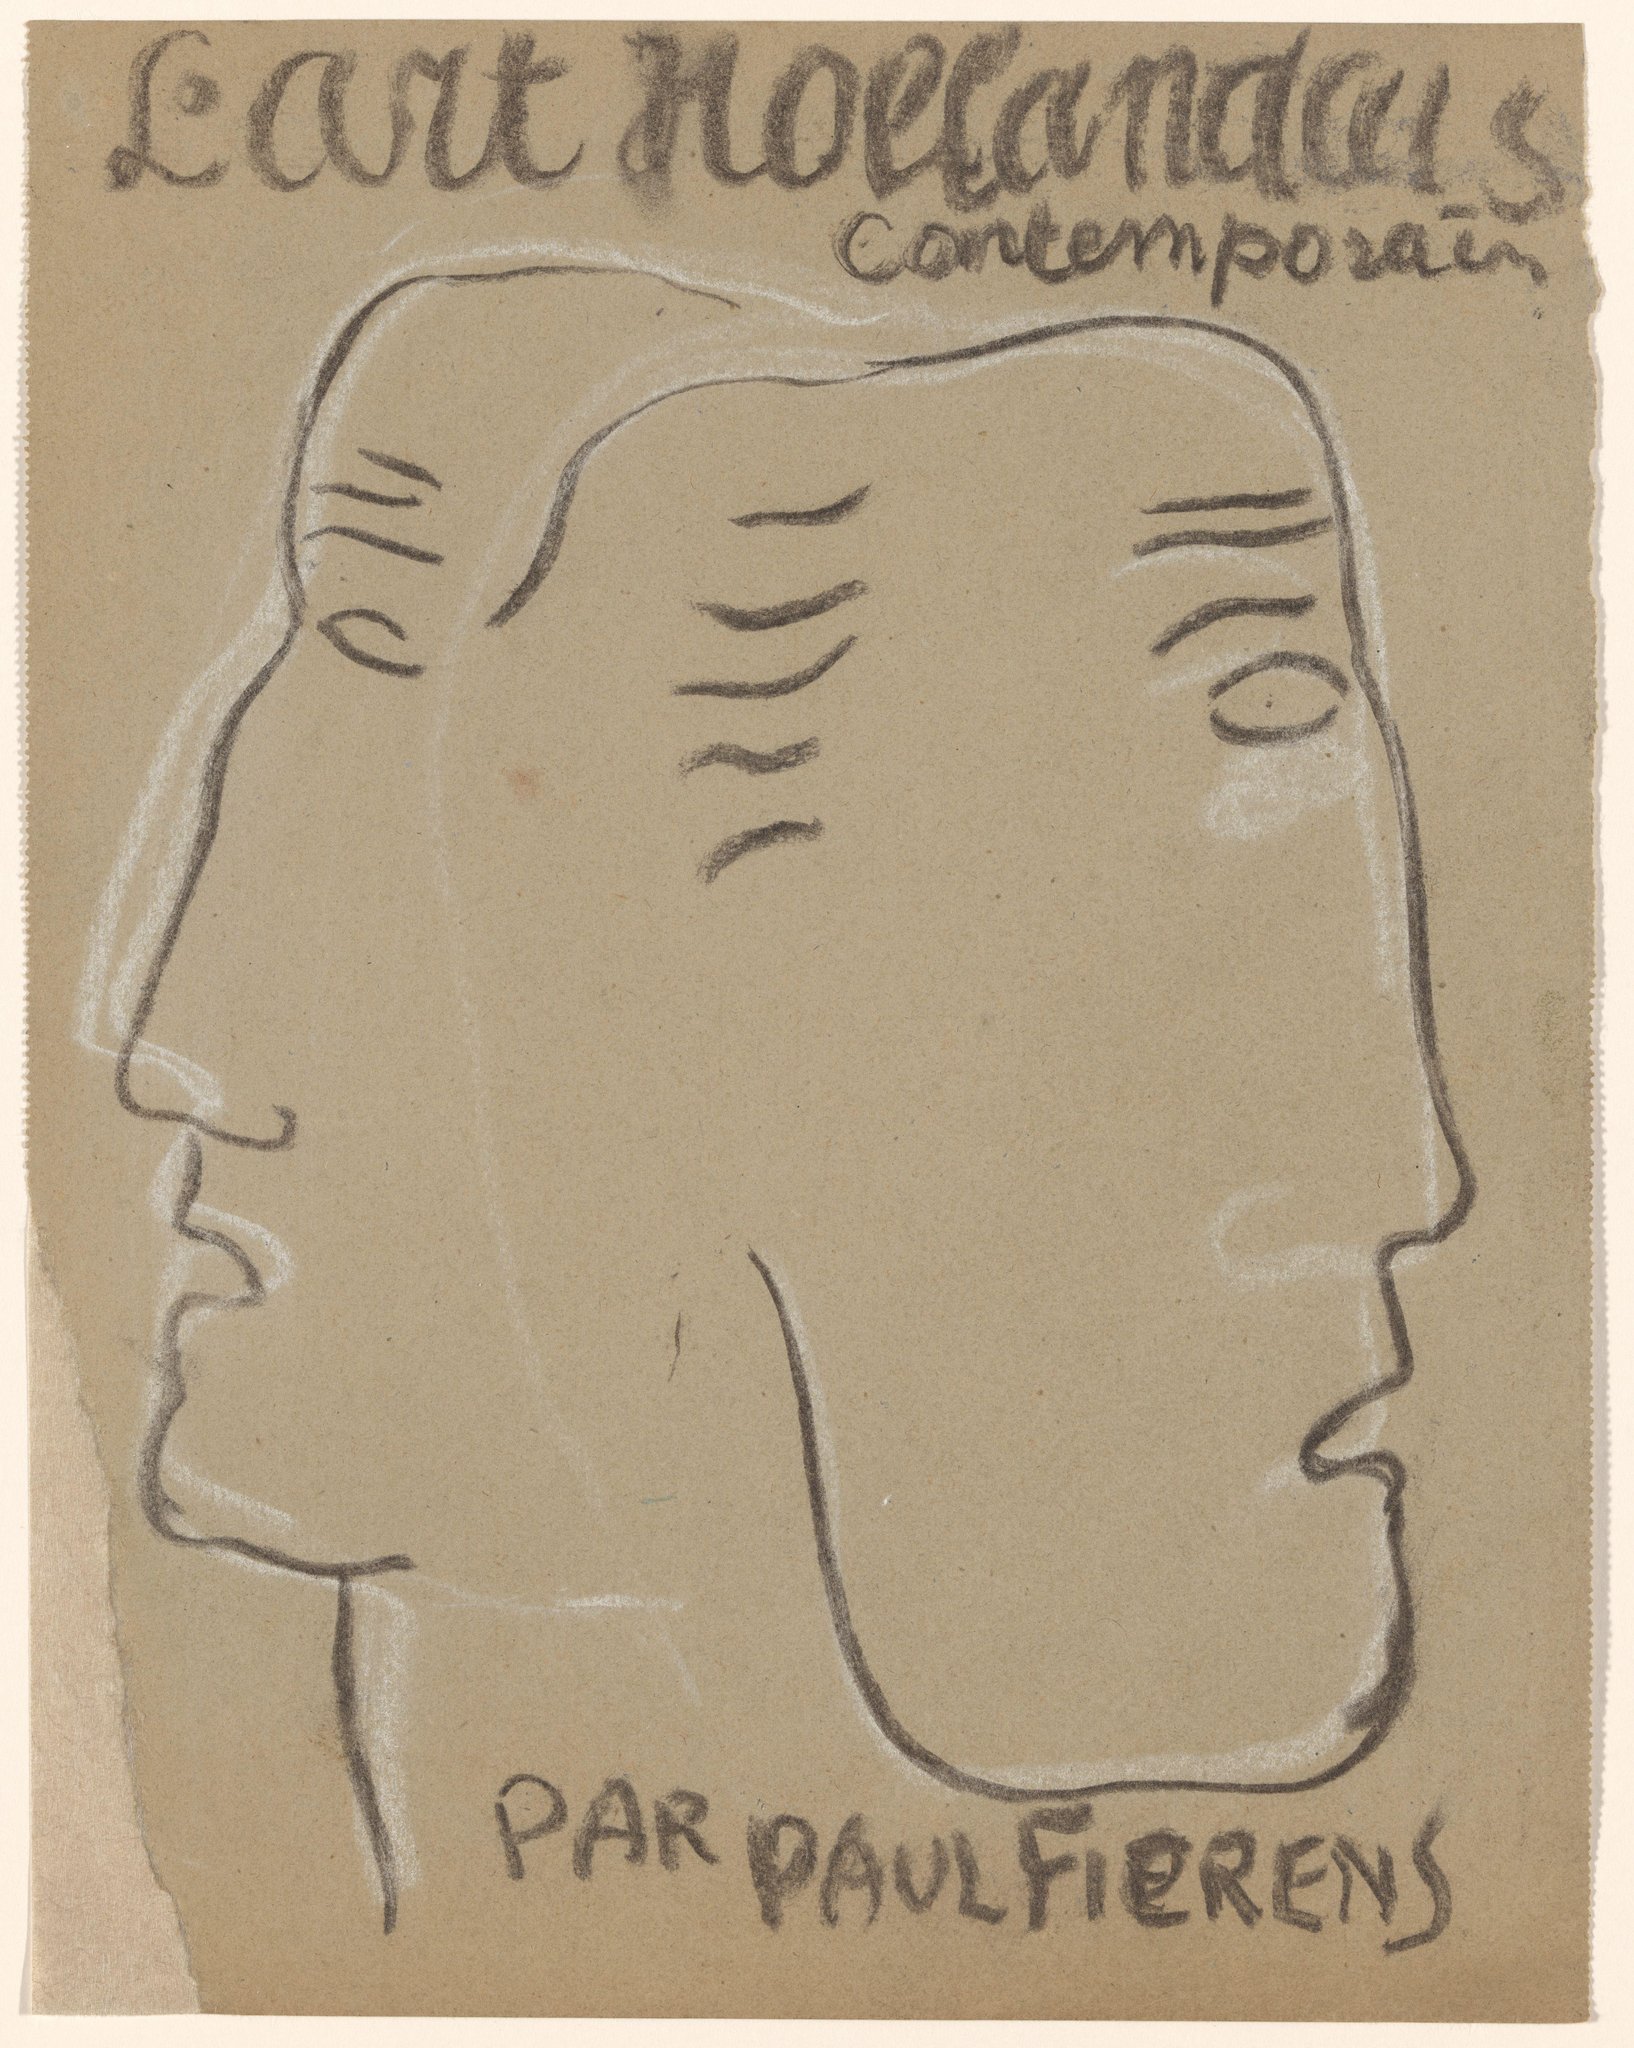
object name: study for binding design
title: Paul Fierens 'L'Art Hollandais contemporain'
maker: leo gestel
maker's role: draughtsman, print maker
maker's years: 1881-1941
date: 1933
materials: chalk, charcoal, paper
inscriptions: inscription: ‘L´art hollandais/ contemporain’, inscription: ‘PAR PAUL FIERENS’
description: Twee gezichten en profil, weergegeven in enkele witte en zwarte lijnen; ontwerp voor boekomslag Paul Fierens 'L'Art Hollandais contemporain'.